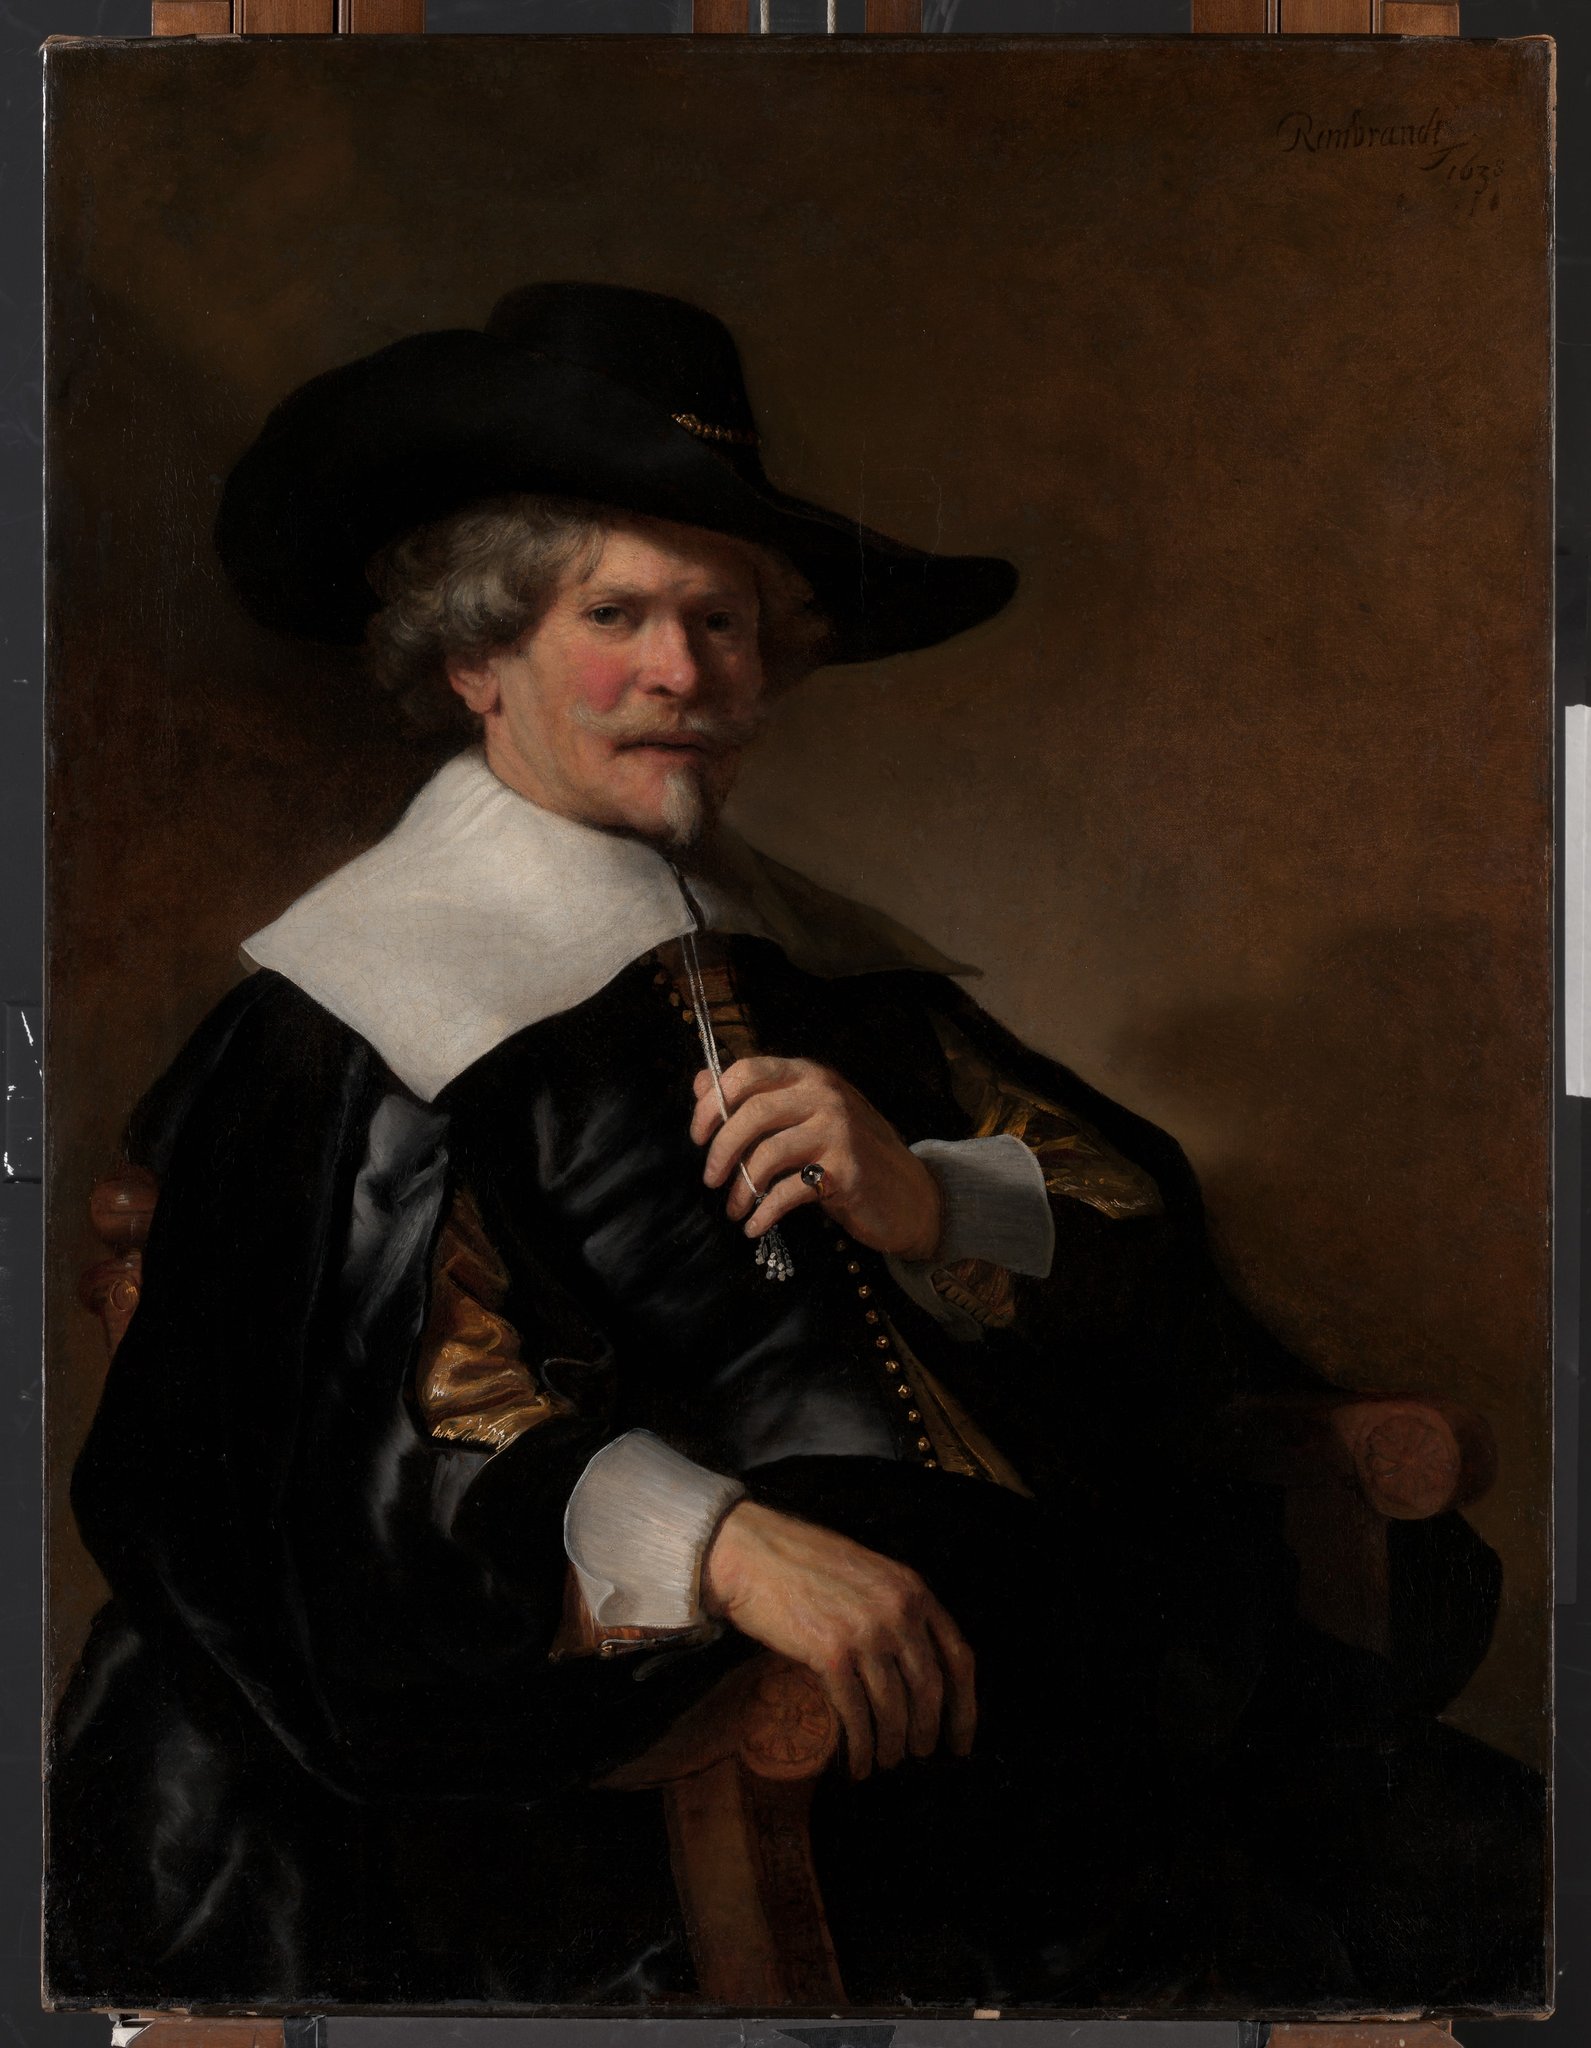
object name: painting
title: Portrait of a Man Seated in an Armchair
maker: dutch (amsterdam) painter, about 1640–50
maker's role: artist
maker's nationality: dutch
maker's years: 1640-1650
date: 1640-1650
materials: canvas, oil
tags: men,portraits